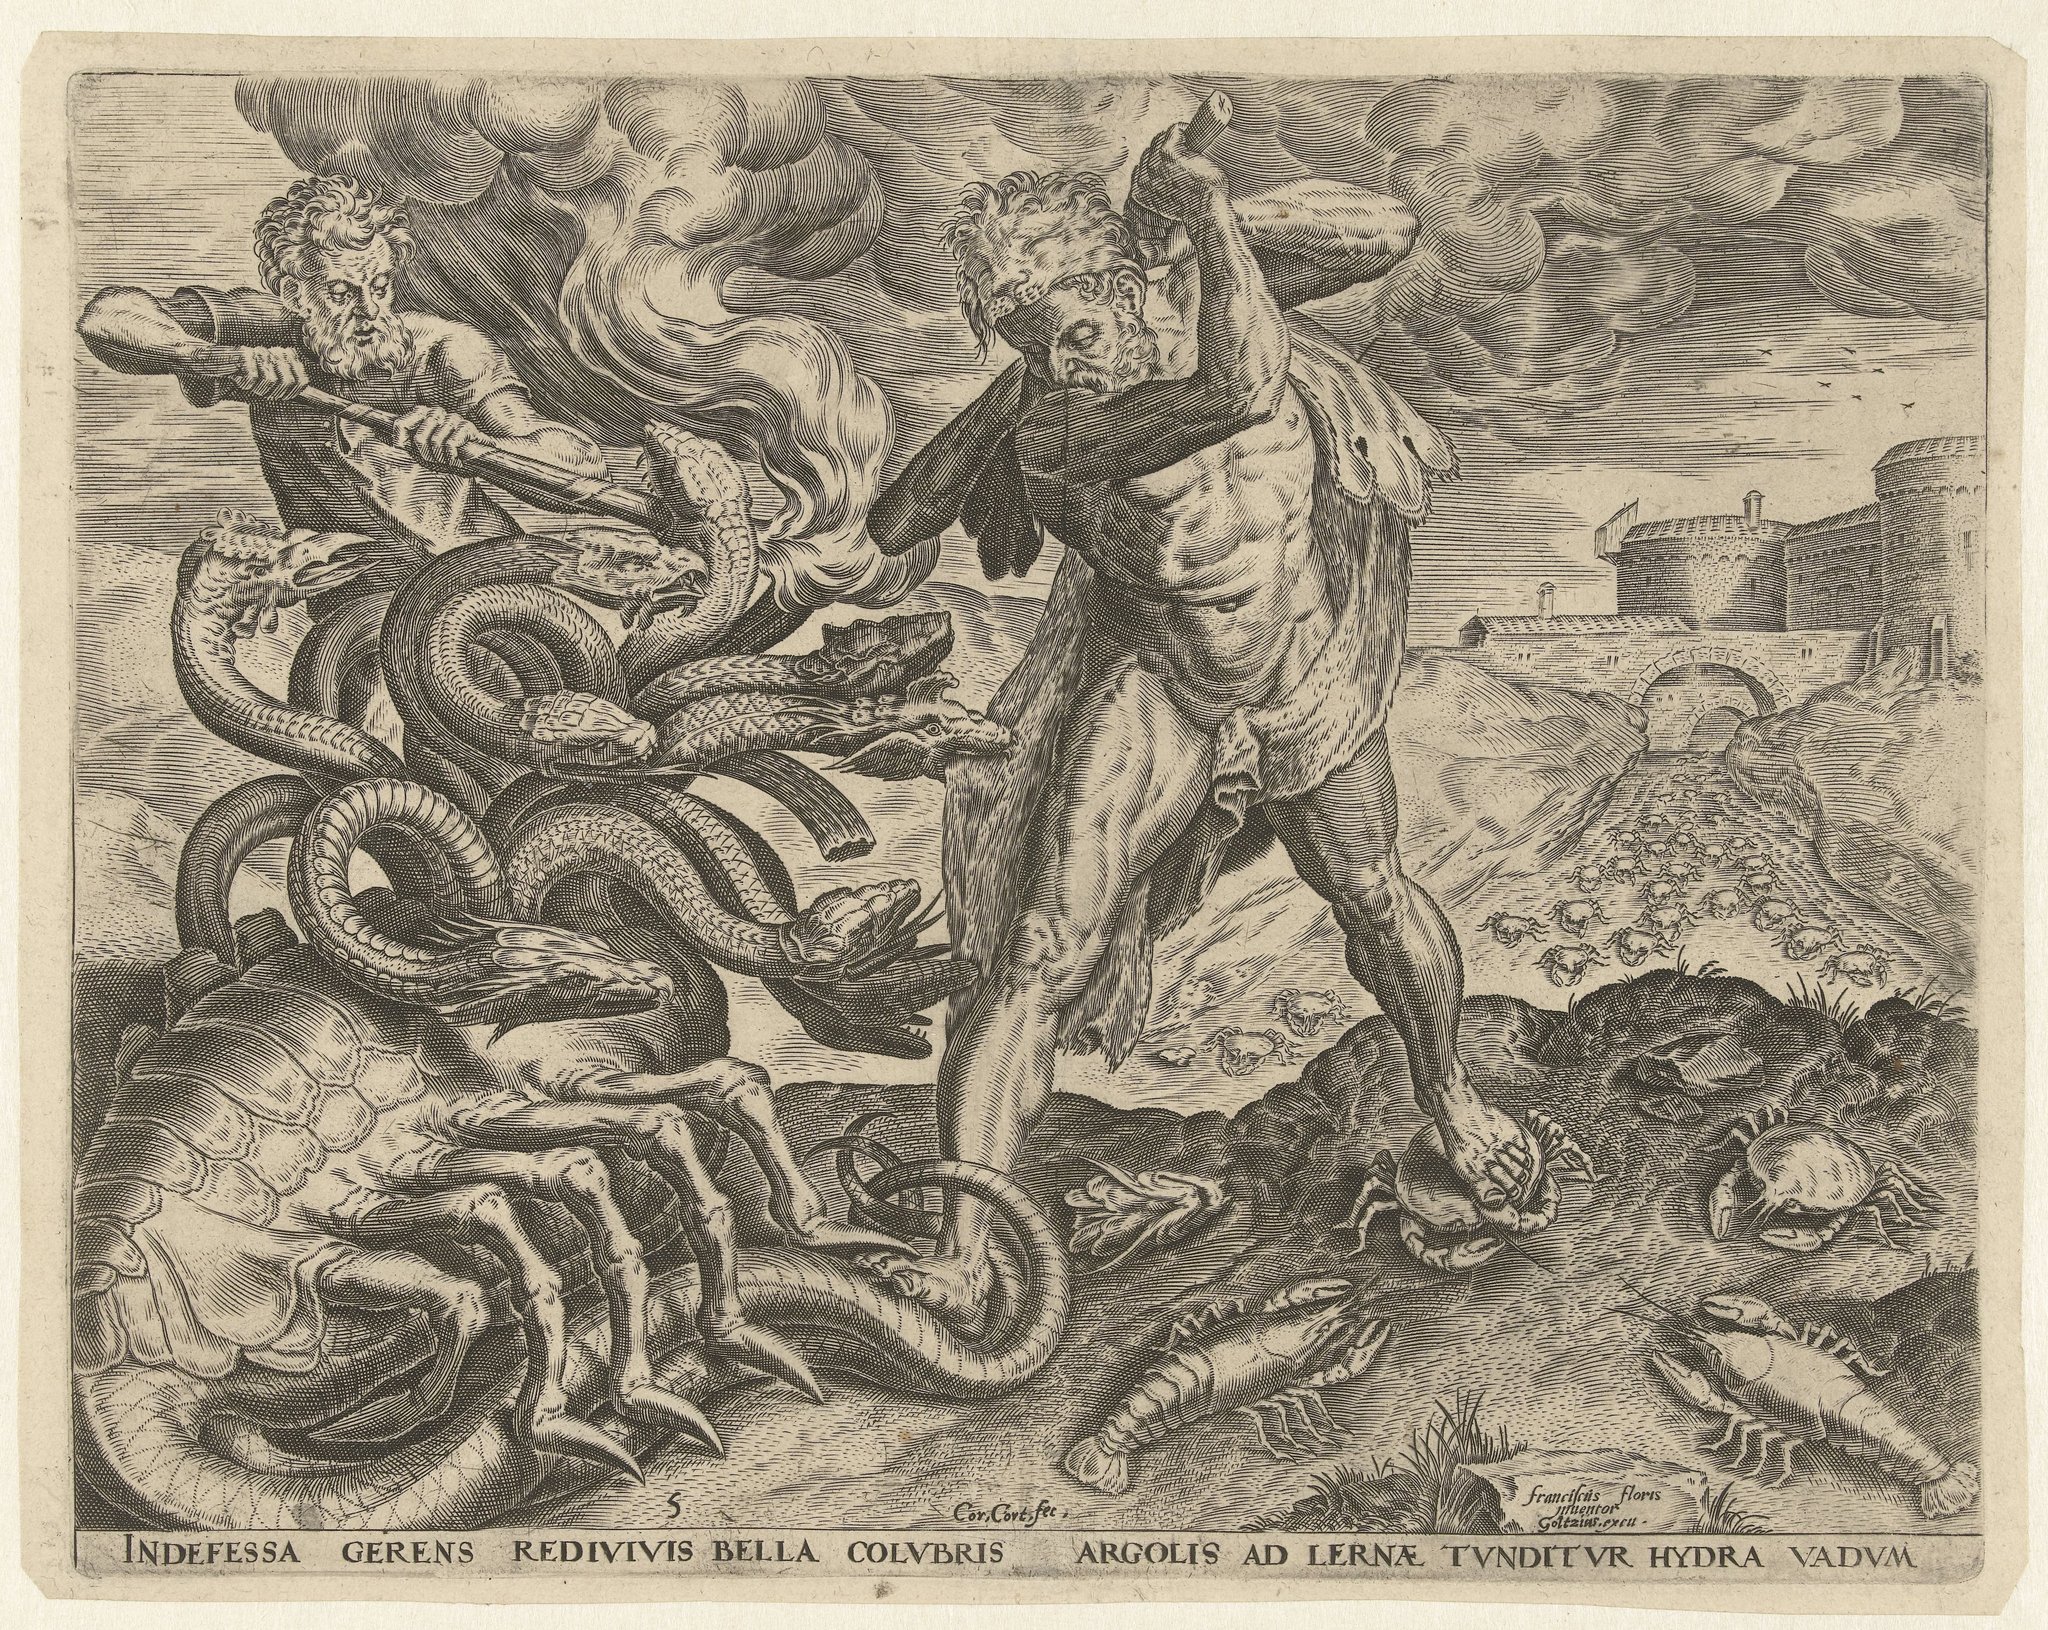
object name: print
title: Hercules overwint de hydra van Lerna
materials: paper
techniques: engraving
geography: antwerp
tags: the hydra is killed by hercules assisted by iolaus, who sears the roots of the severed heads with burning brands; an enormous crab nips hercules' foot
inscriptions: collector's mark: Lugt 2228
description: Hercules overwint met de hulp van zijn neef de hydra van Lerna. Hij slaat met zijn knots de hoofden van dit meerkoppige monster af en zijn neef schroeit de halzen dicht zodat er geen nieuwe hoofden kunnen groeien. Hercules wordt door een krab in zijn voet gebeten. De krabben zijn door Juno gestuurd om Hercules bij zijn taken te hinderen.